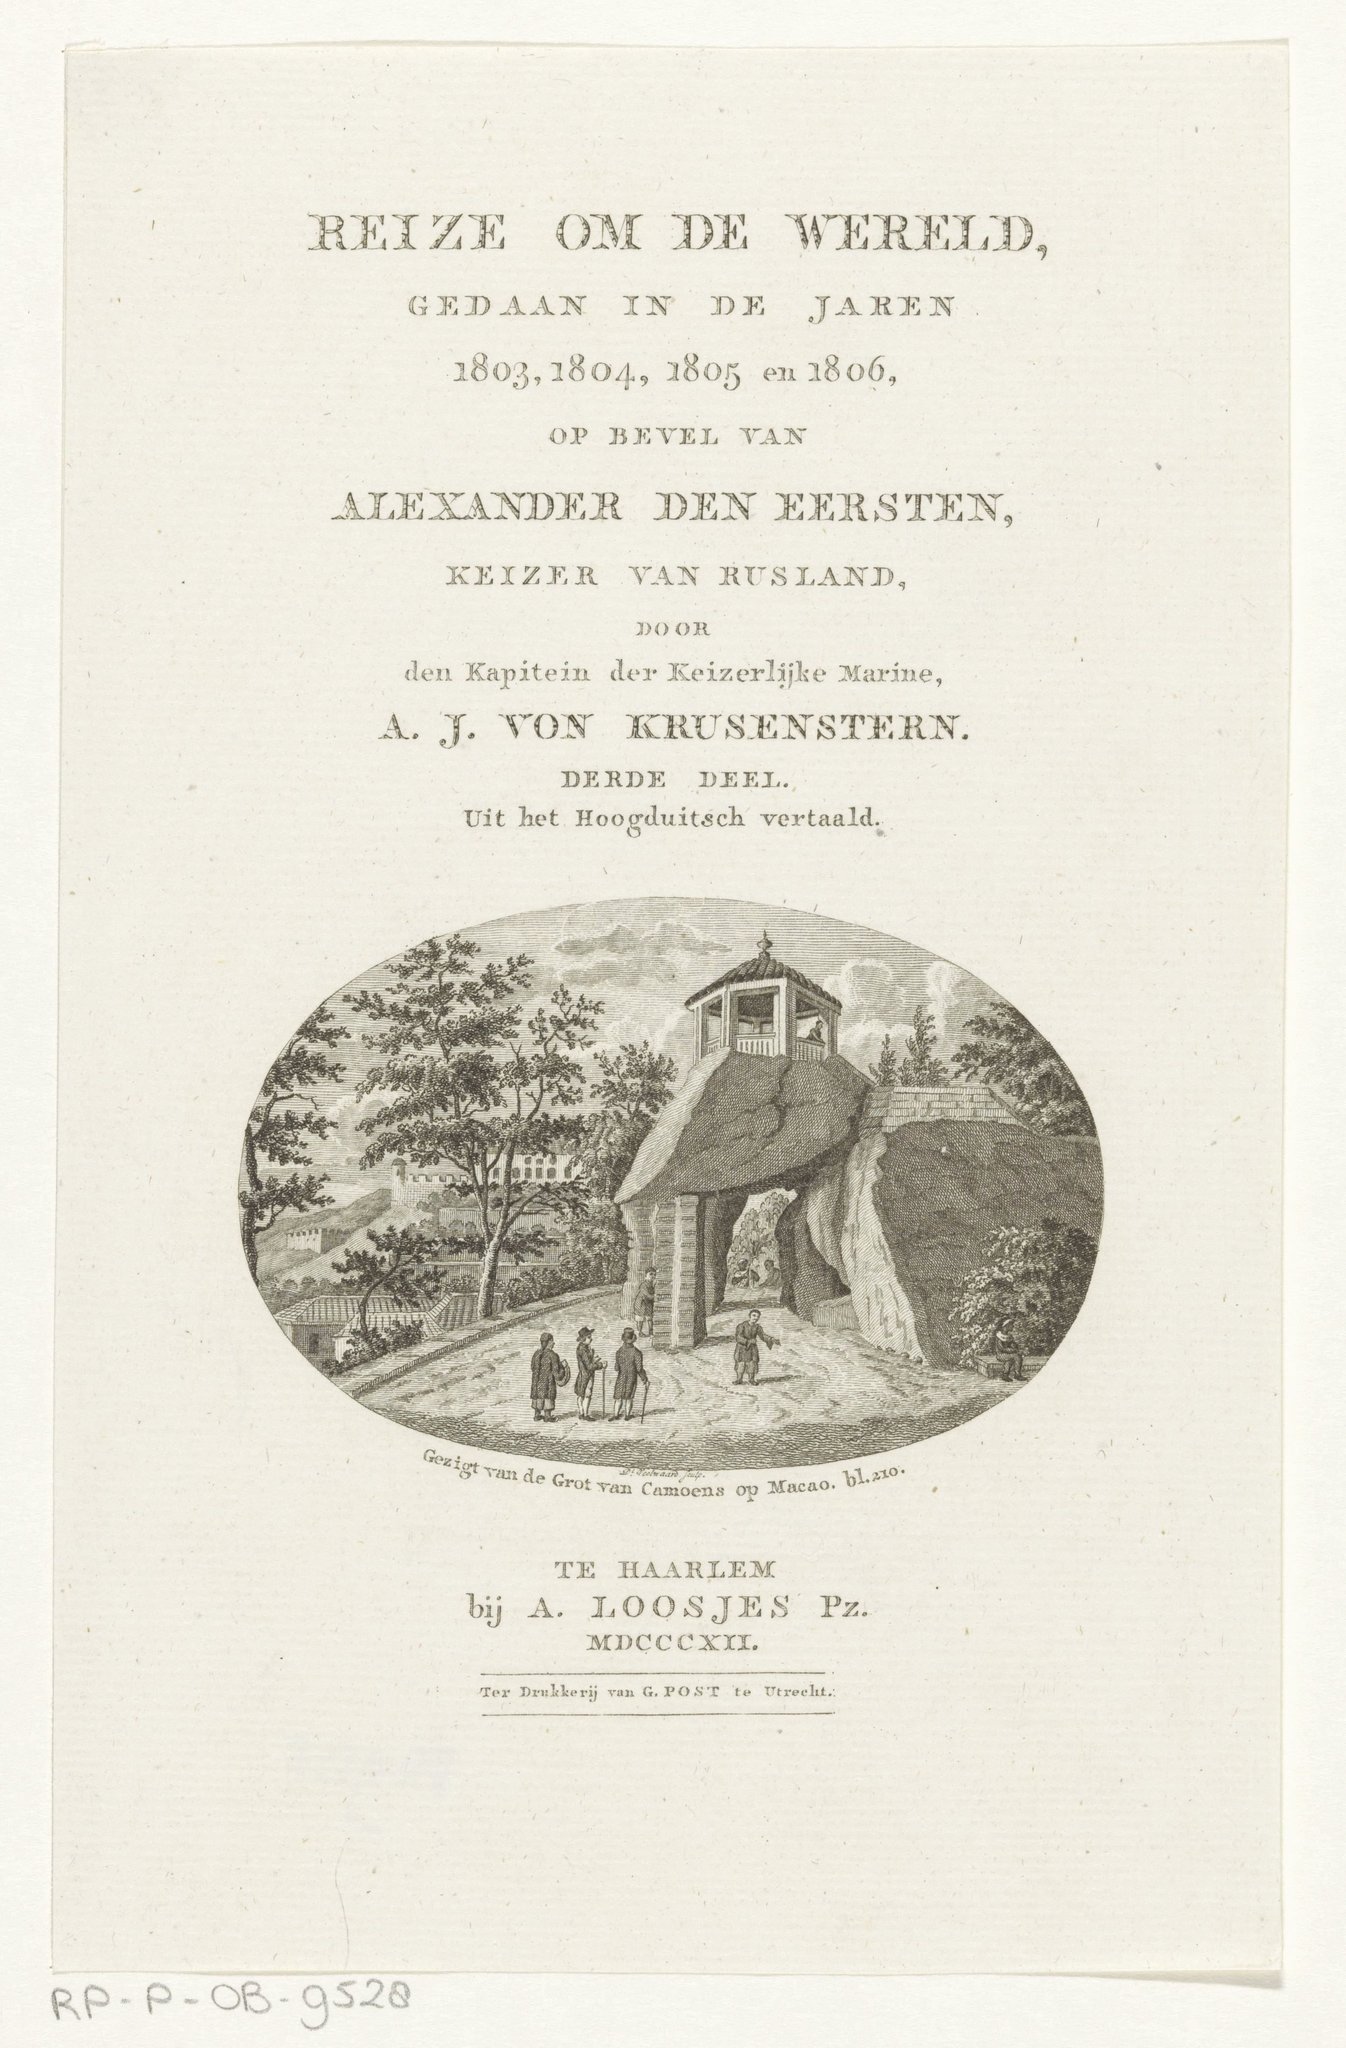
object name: titelblad, titelpagina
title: Tuin met grot in Macao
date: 1812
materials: paper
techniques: engraving, etching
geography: haarlem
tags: garden, cave, grotto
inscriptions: collector's mark: Lugt 2228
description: Titelpagina voor: Krusenstern, A.J. von. Reize om de wereld, gedaan in de jaren 1803, 1804, 1805 en 1806, op bevel van Alexander den Eersten, keizer van Rusland. Derde deel. Haarlem: Loosjes, Adriaan Pietersz., 1812.